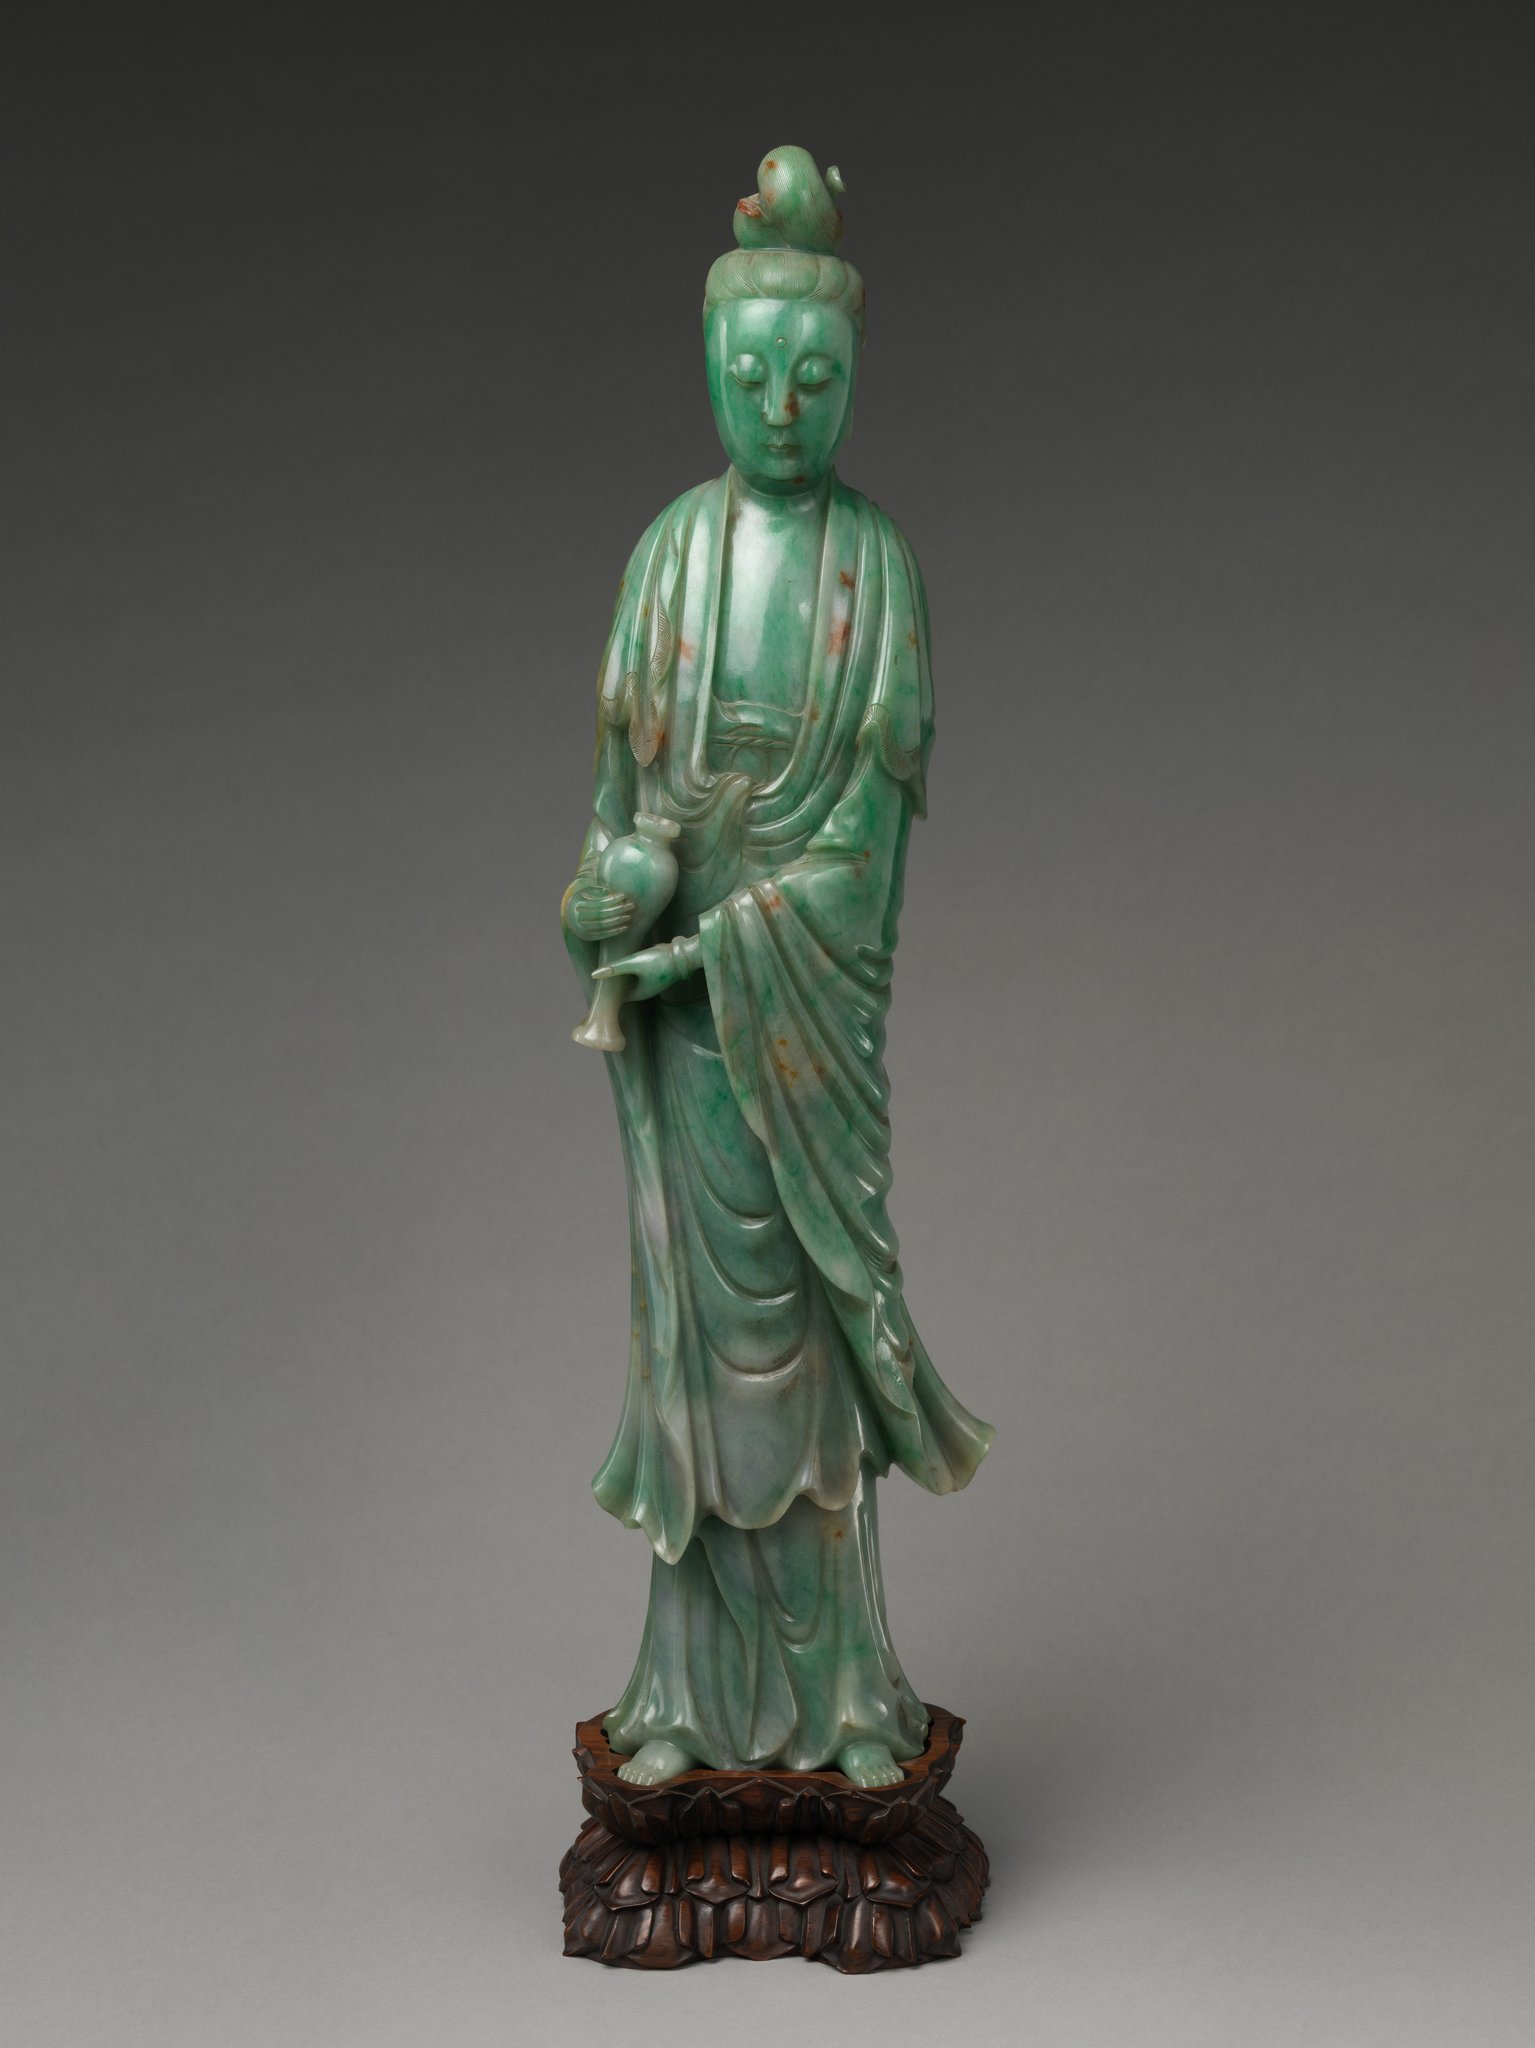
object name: figure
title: Bodhisattva Guanyin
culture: chinese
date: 1801-1900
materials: jade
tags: bodhisattvas